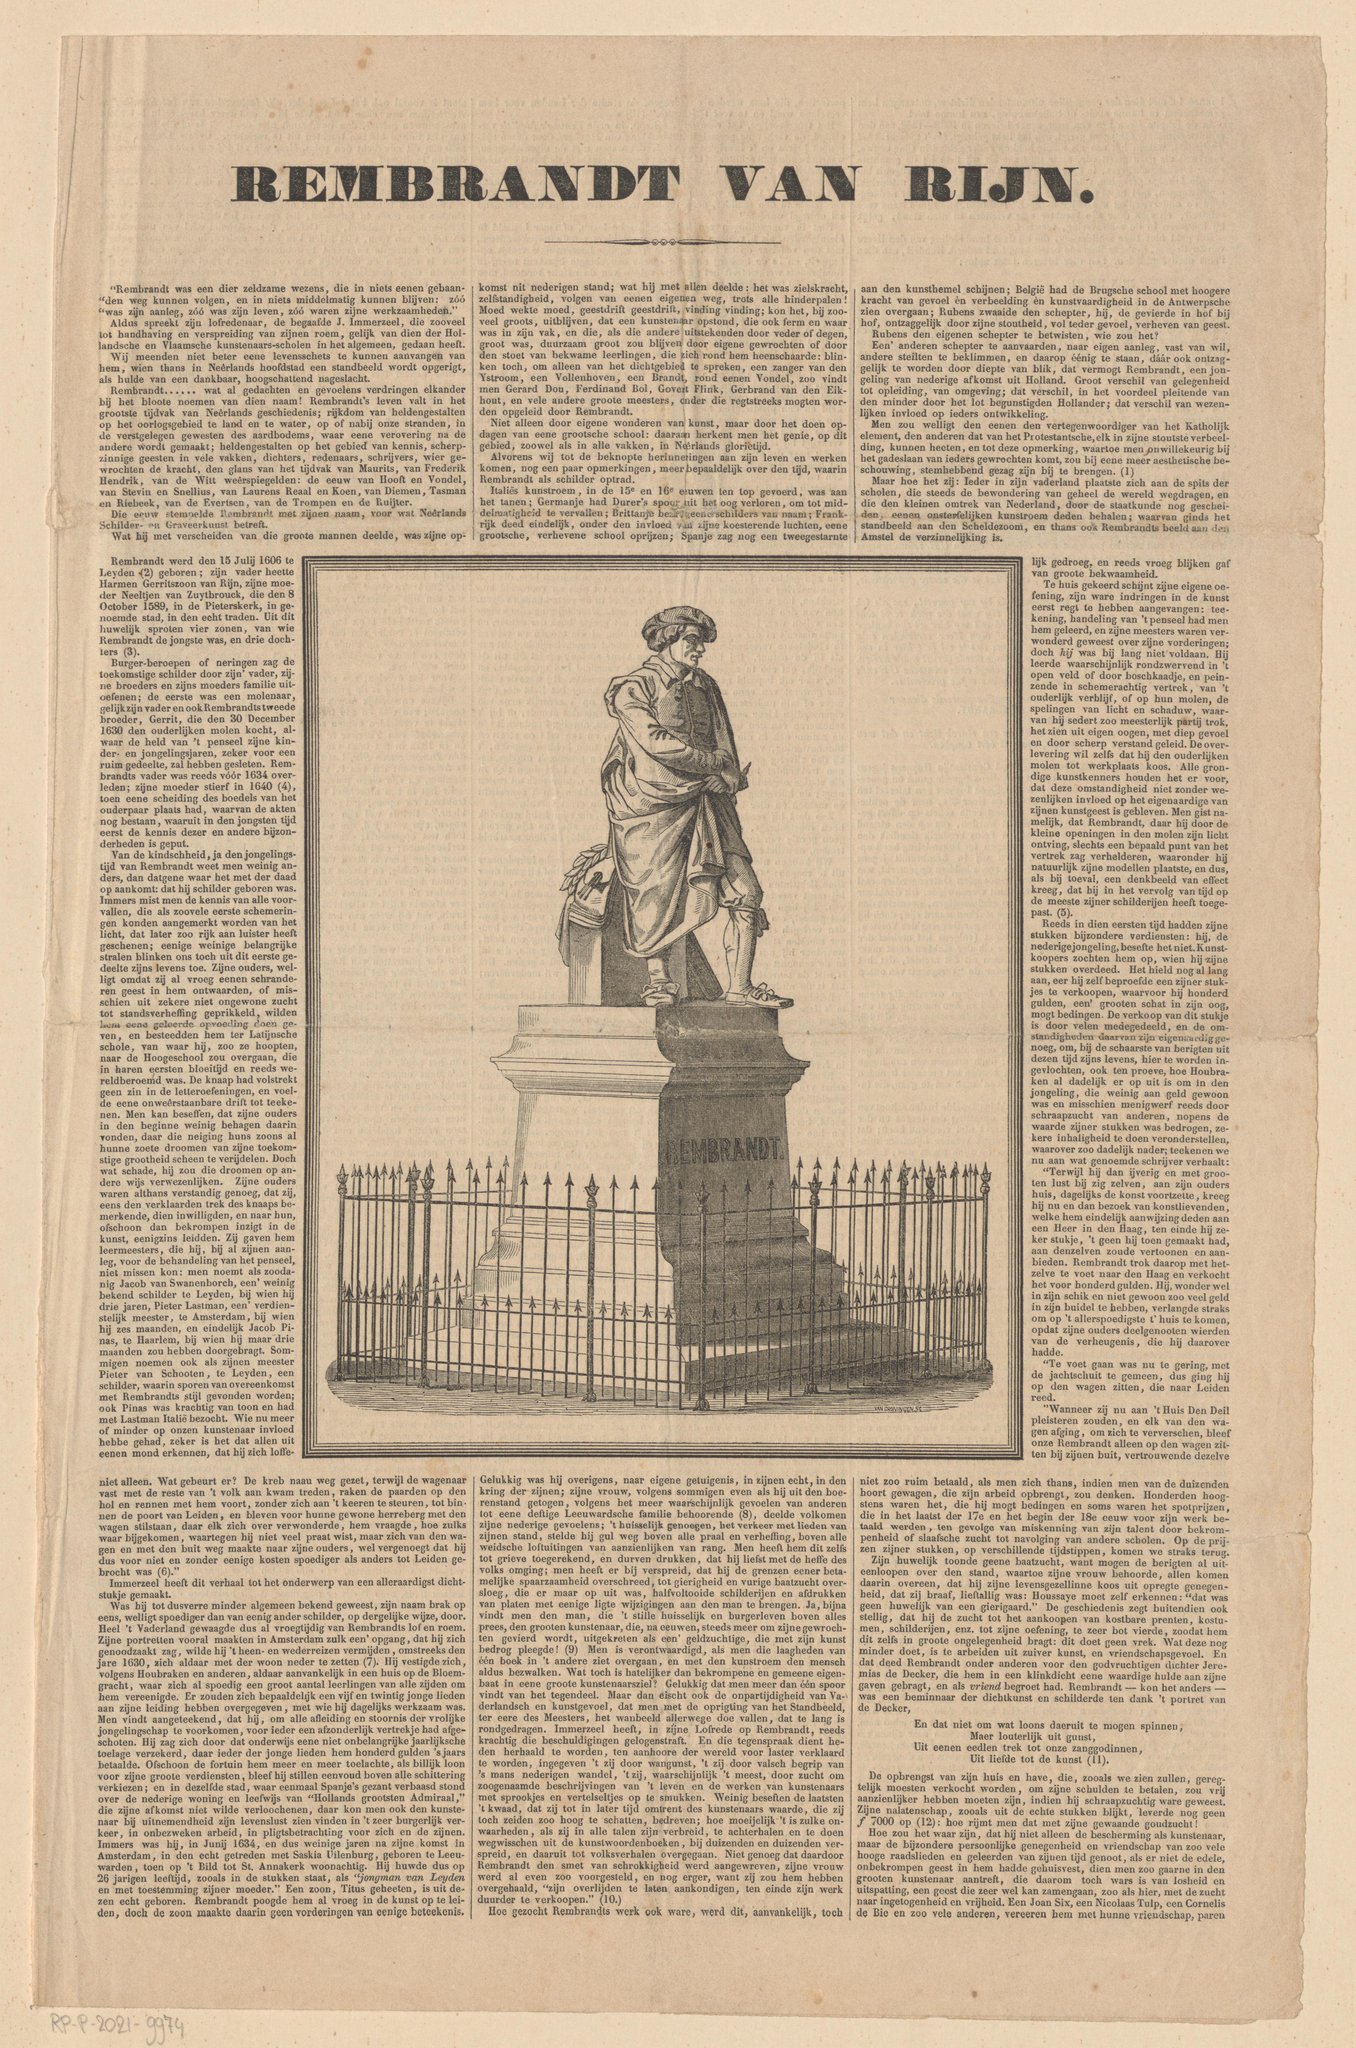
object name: print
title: Portret van Rembrandt van Rijn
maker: popko van groningen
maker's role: print maker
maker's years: 1822-1888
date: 1852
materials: paper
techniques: letterpress printing, engraving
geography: amsterdam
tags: leiden, amsterdam, painter, print maker, draughtsman, rembrandt van rijn, historical persons, portrait, self-portrait of painter, monument, statue